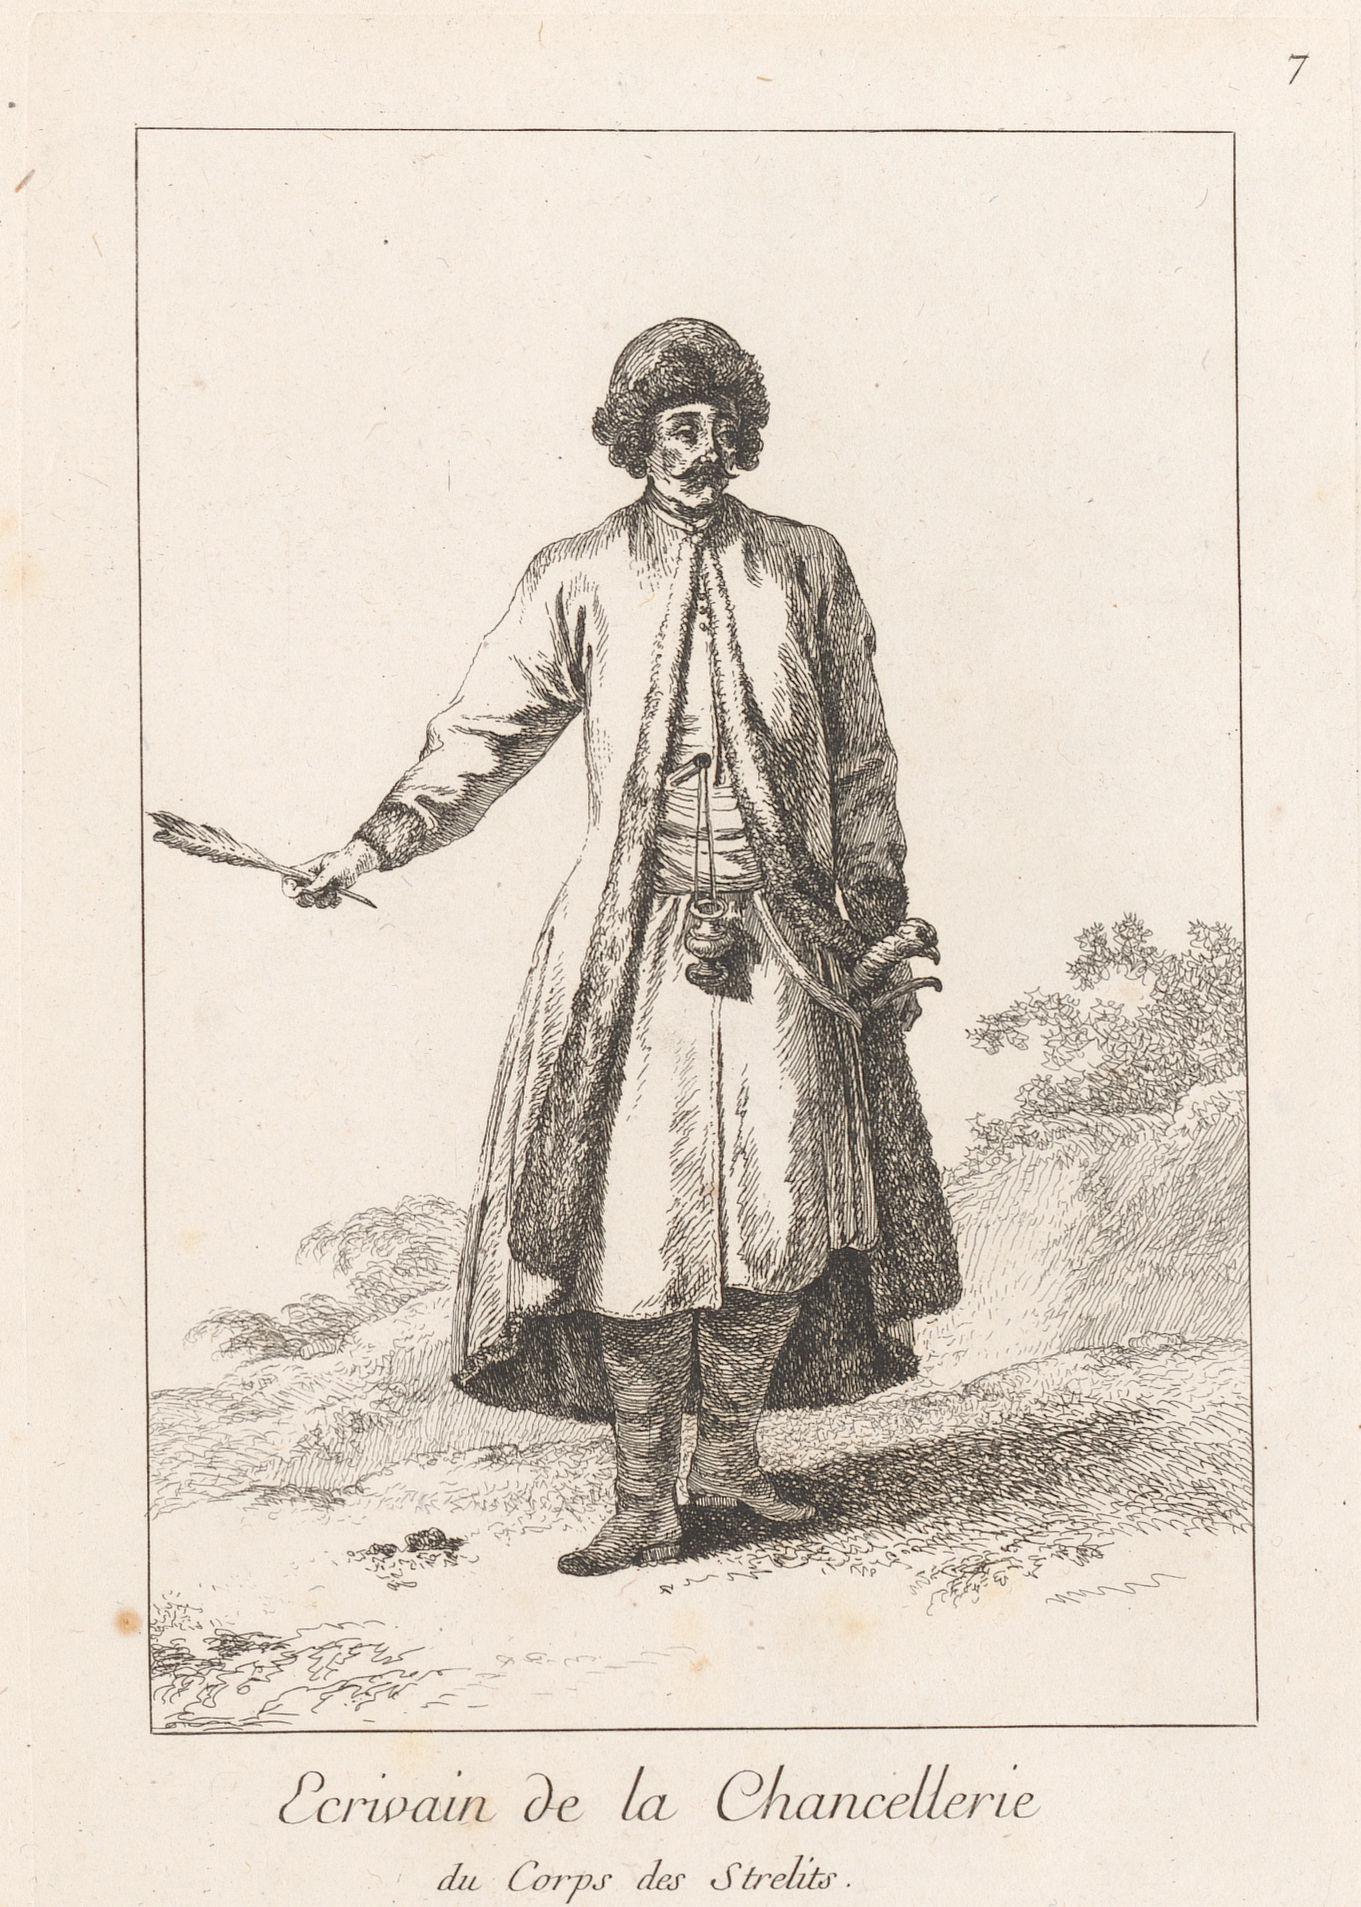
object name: album leaf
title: Schrijver van het korps Strelitsen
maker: jean baptist leprince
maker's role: draughtsman, print maker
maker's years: 1734-1781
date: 1764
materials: paper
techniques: etching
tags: ranks in the army, writer, poet, author